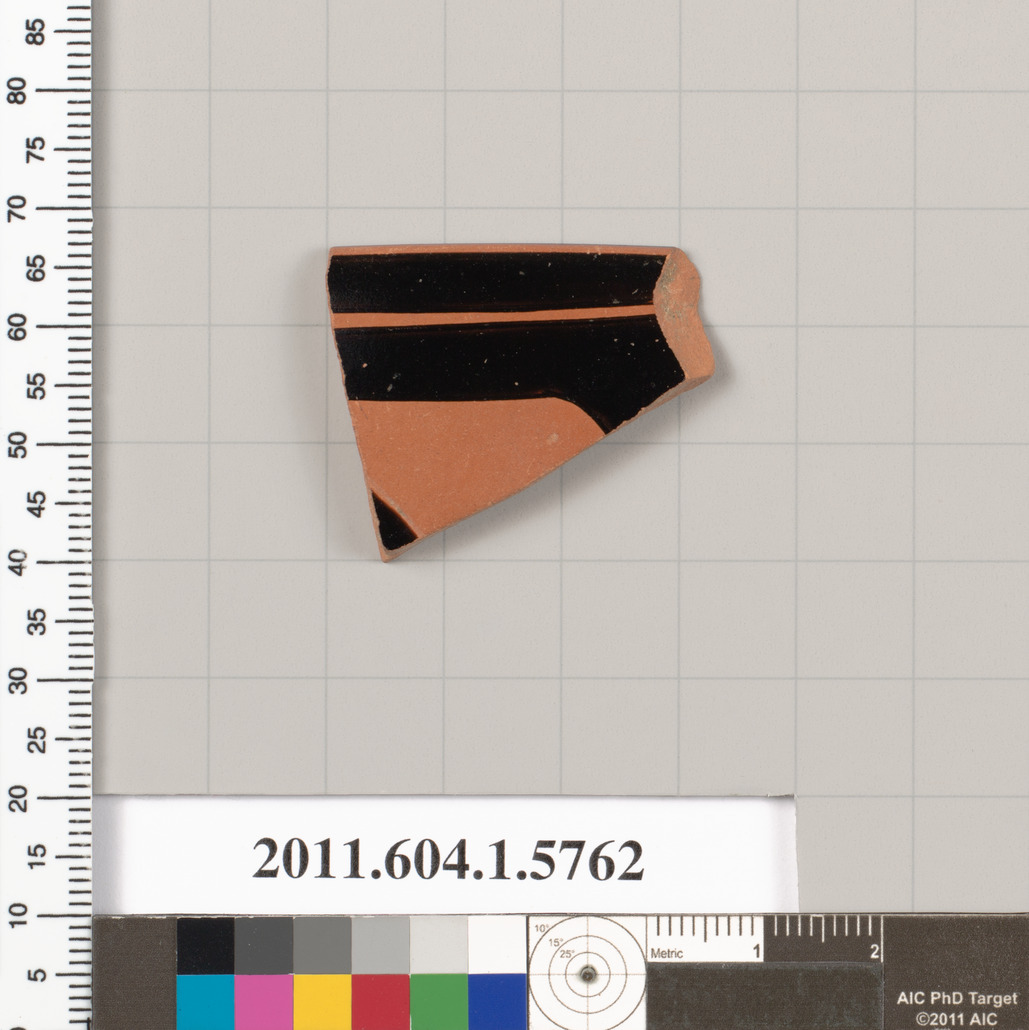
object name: kylix fragment, eye cup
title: Terracotta rim fragment of a kylix: eye-cup (drinking cup)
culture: greek, attic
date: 520-510 BCE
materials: terracotta